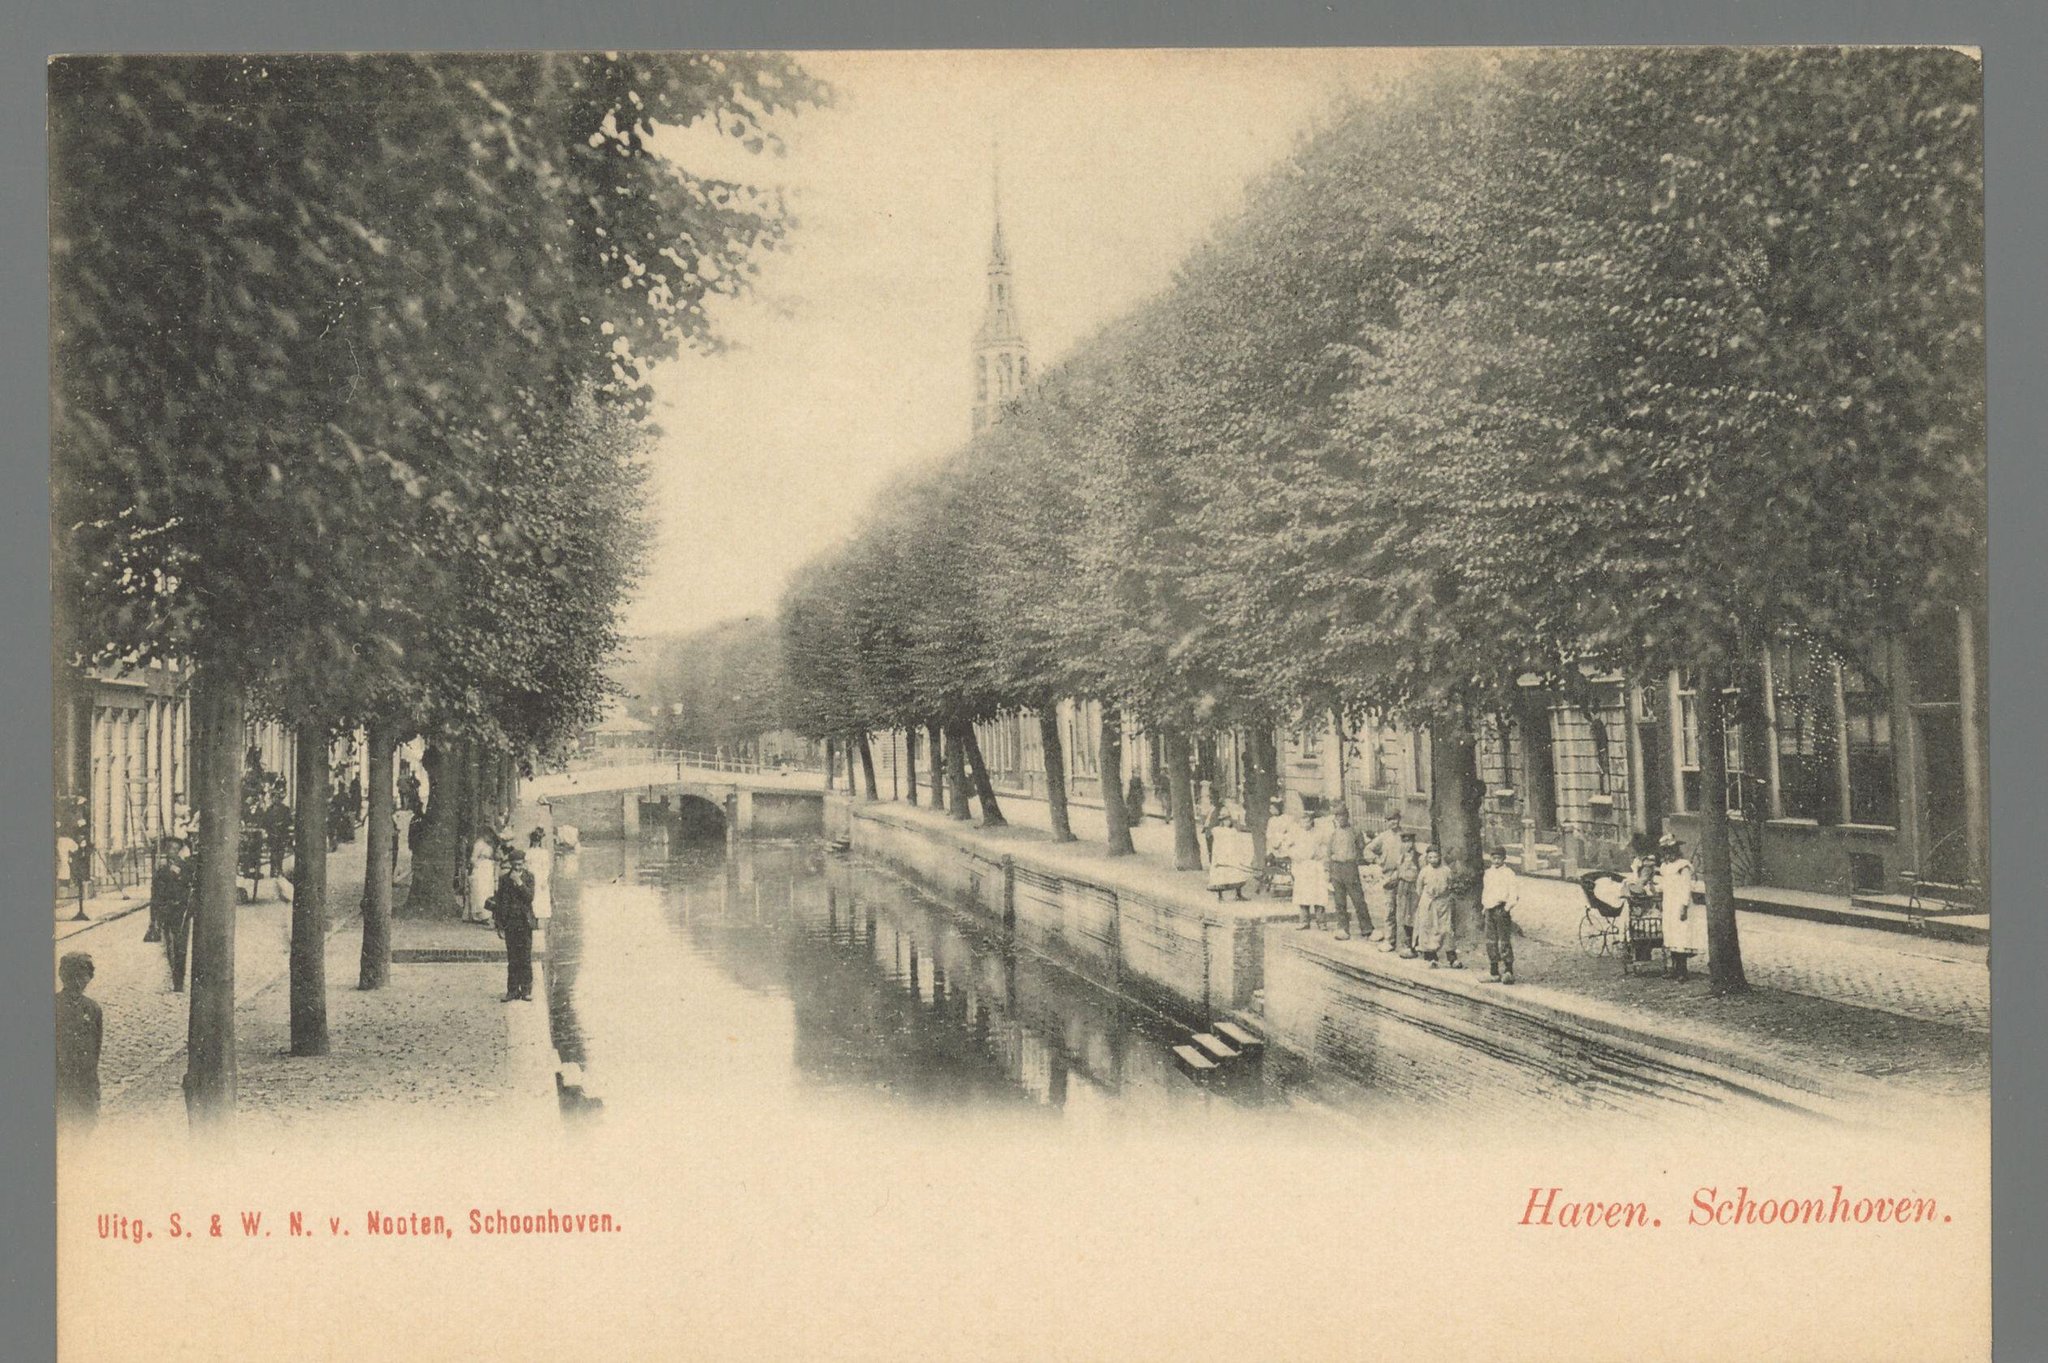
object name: photomechanical print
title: Haven, Schoonhoven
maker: Anonymous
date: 1897-1905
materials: cardboard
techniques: photograph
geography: schoonhoven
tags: canals, waters (in village), townhall, street, bridge in village across river, canal, etc.